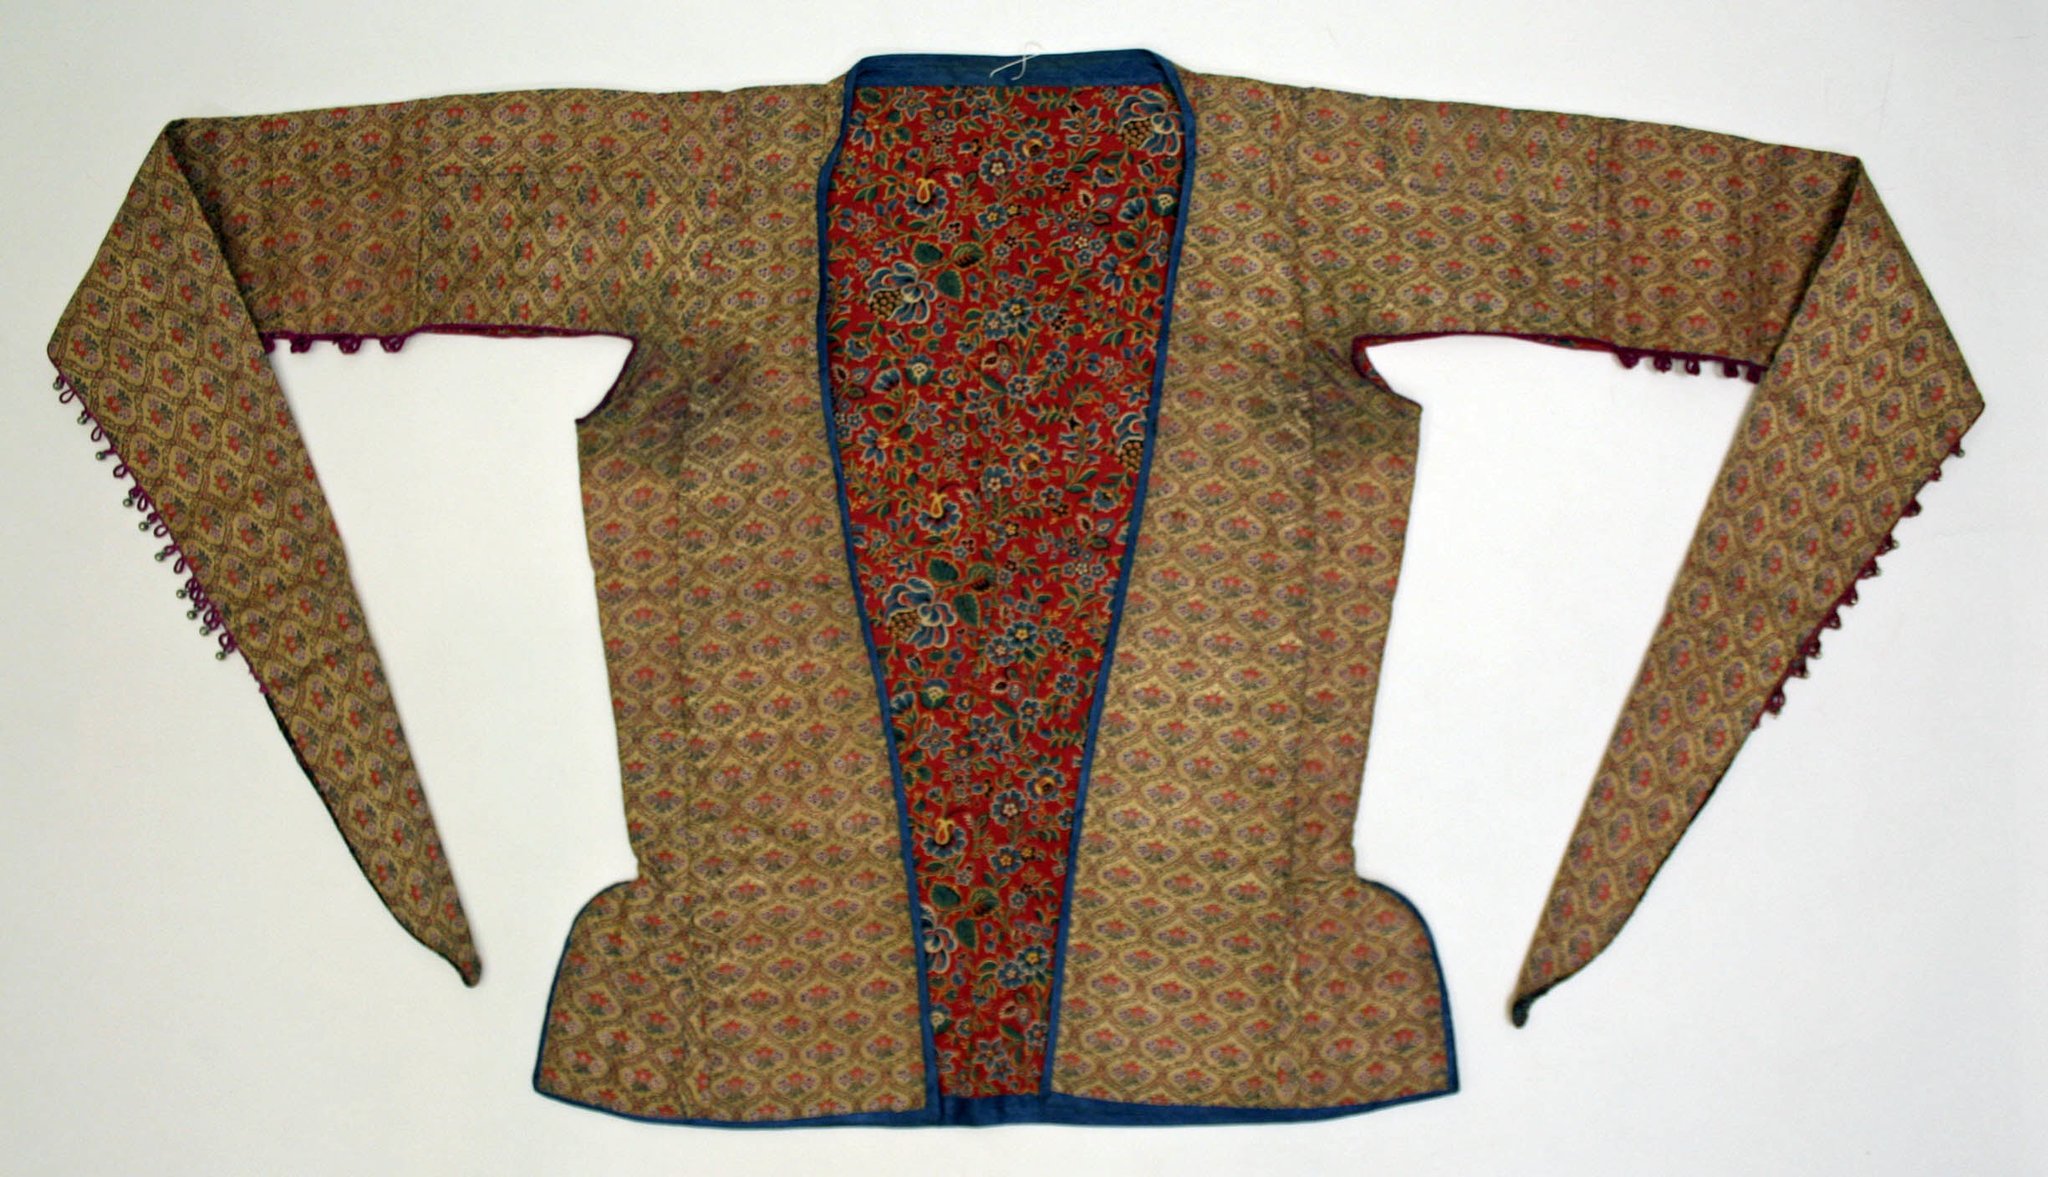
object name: jacket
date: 1801-1900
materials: cotton, metal thread, silk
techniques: brocade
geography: iran